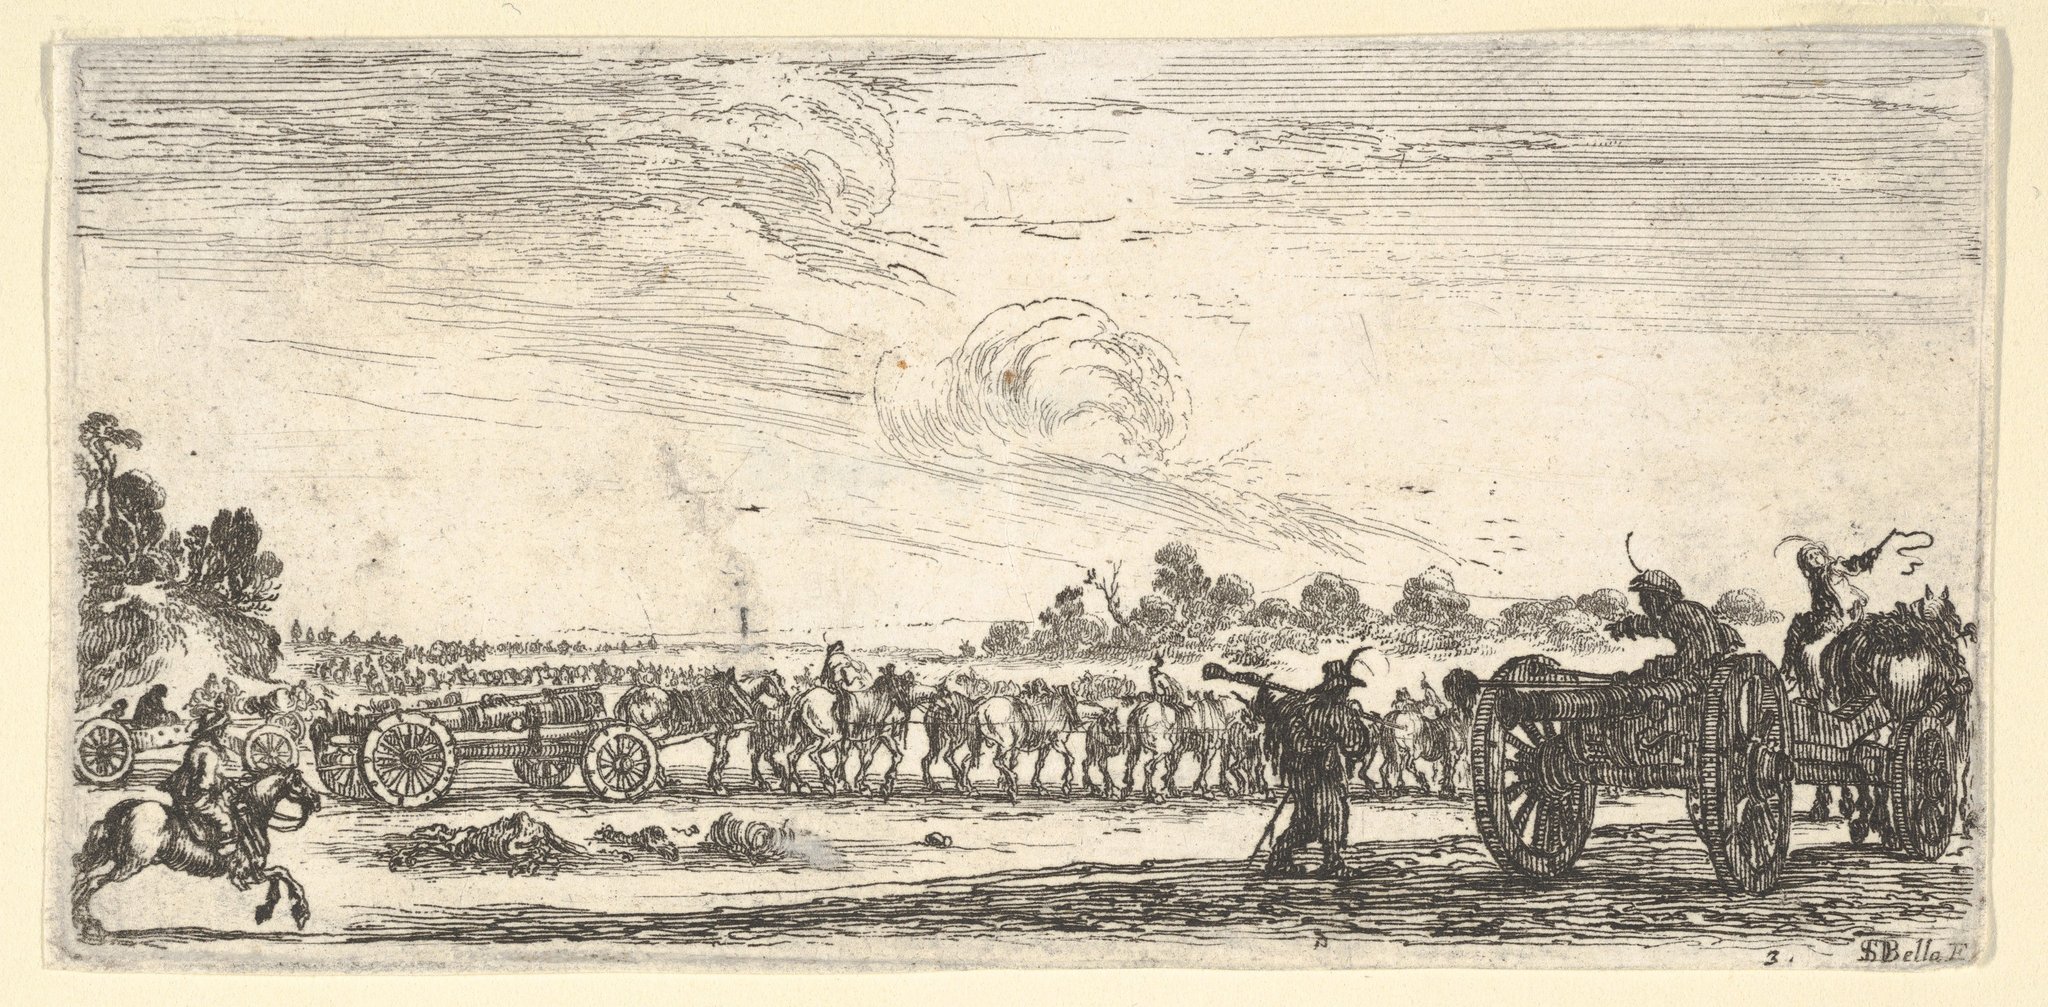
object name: print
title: Plate 3: a procession of horse-drawn cannons, riding to the right, a horse-drawn cannon to the right seen from the back, from "Troops, cannons, and attacks on towns" (Dessins de quelques conduites de troupes, canons, et ataques de villes)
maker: stefano della bella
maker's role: artist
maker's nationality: italian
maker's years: 1610-1664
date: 1640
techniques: etching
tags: soldiers,cannons,horses